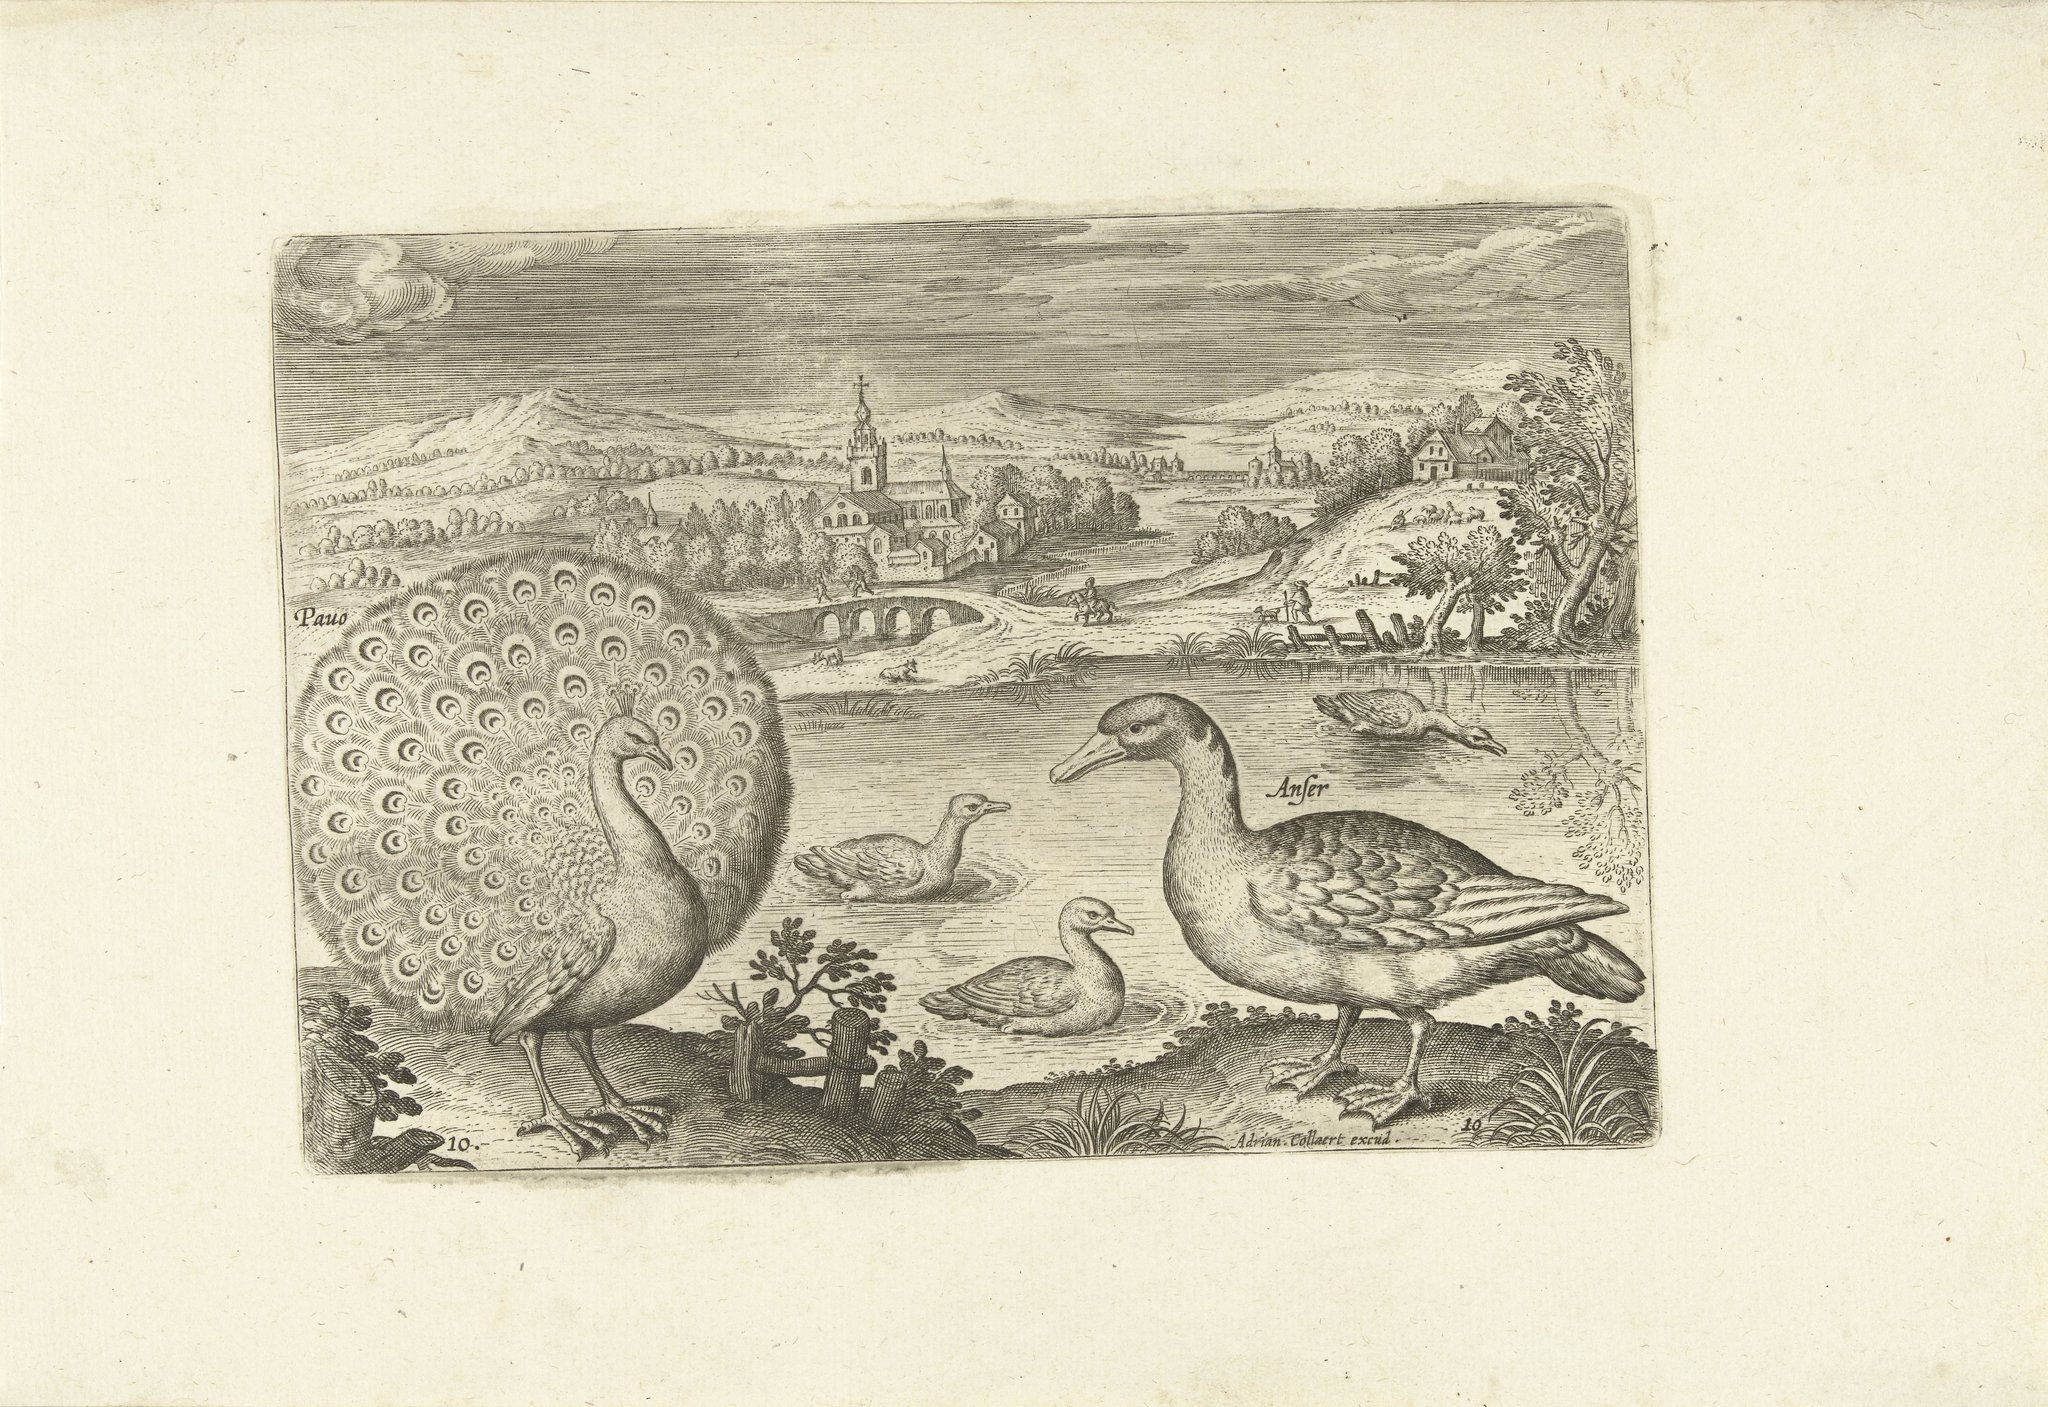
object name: print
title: Avivm vivae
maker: adriaen collaert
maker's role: draughtsman, print maker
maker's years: 1560-1618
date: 1598-1602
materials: paper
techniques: engraving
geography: antwerp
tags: water-birds: goose, ornamental birds: peacock, river (+ landscape with figures, staffage)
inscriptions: collector's mark: Lugt 2228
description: Een pauw en een grijze gans op de voorgrond. Achter hen zwemmen enkele ganzen in een rivier. Op de achtergrond een landschap met een kerk. De prent maakt deel uit van een serie met vogels als onderwerp.